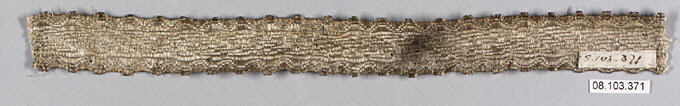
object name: galloon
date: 1601-1800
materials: metal thread